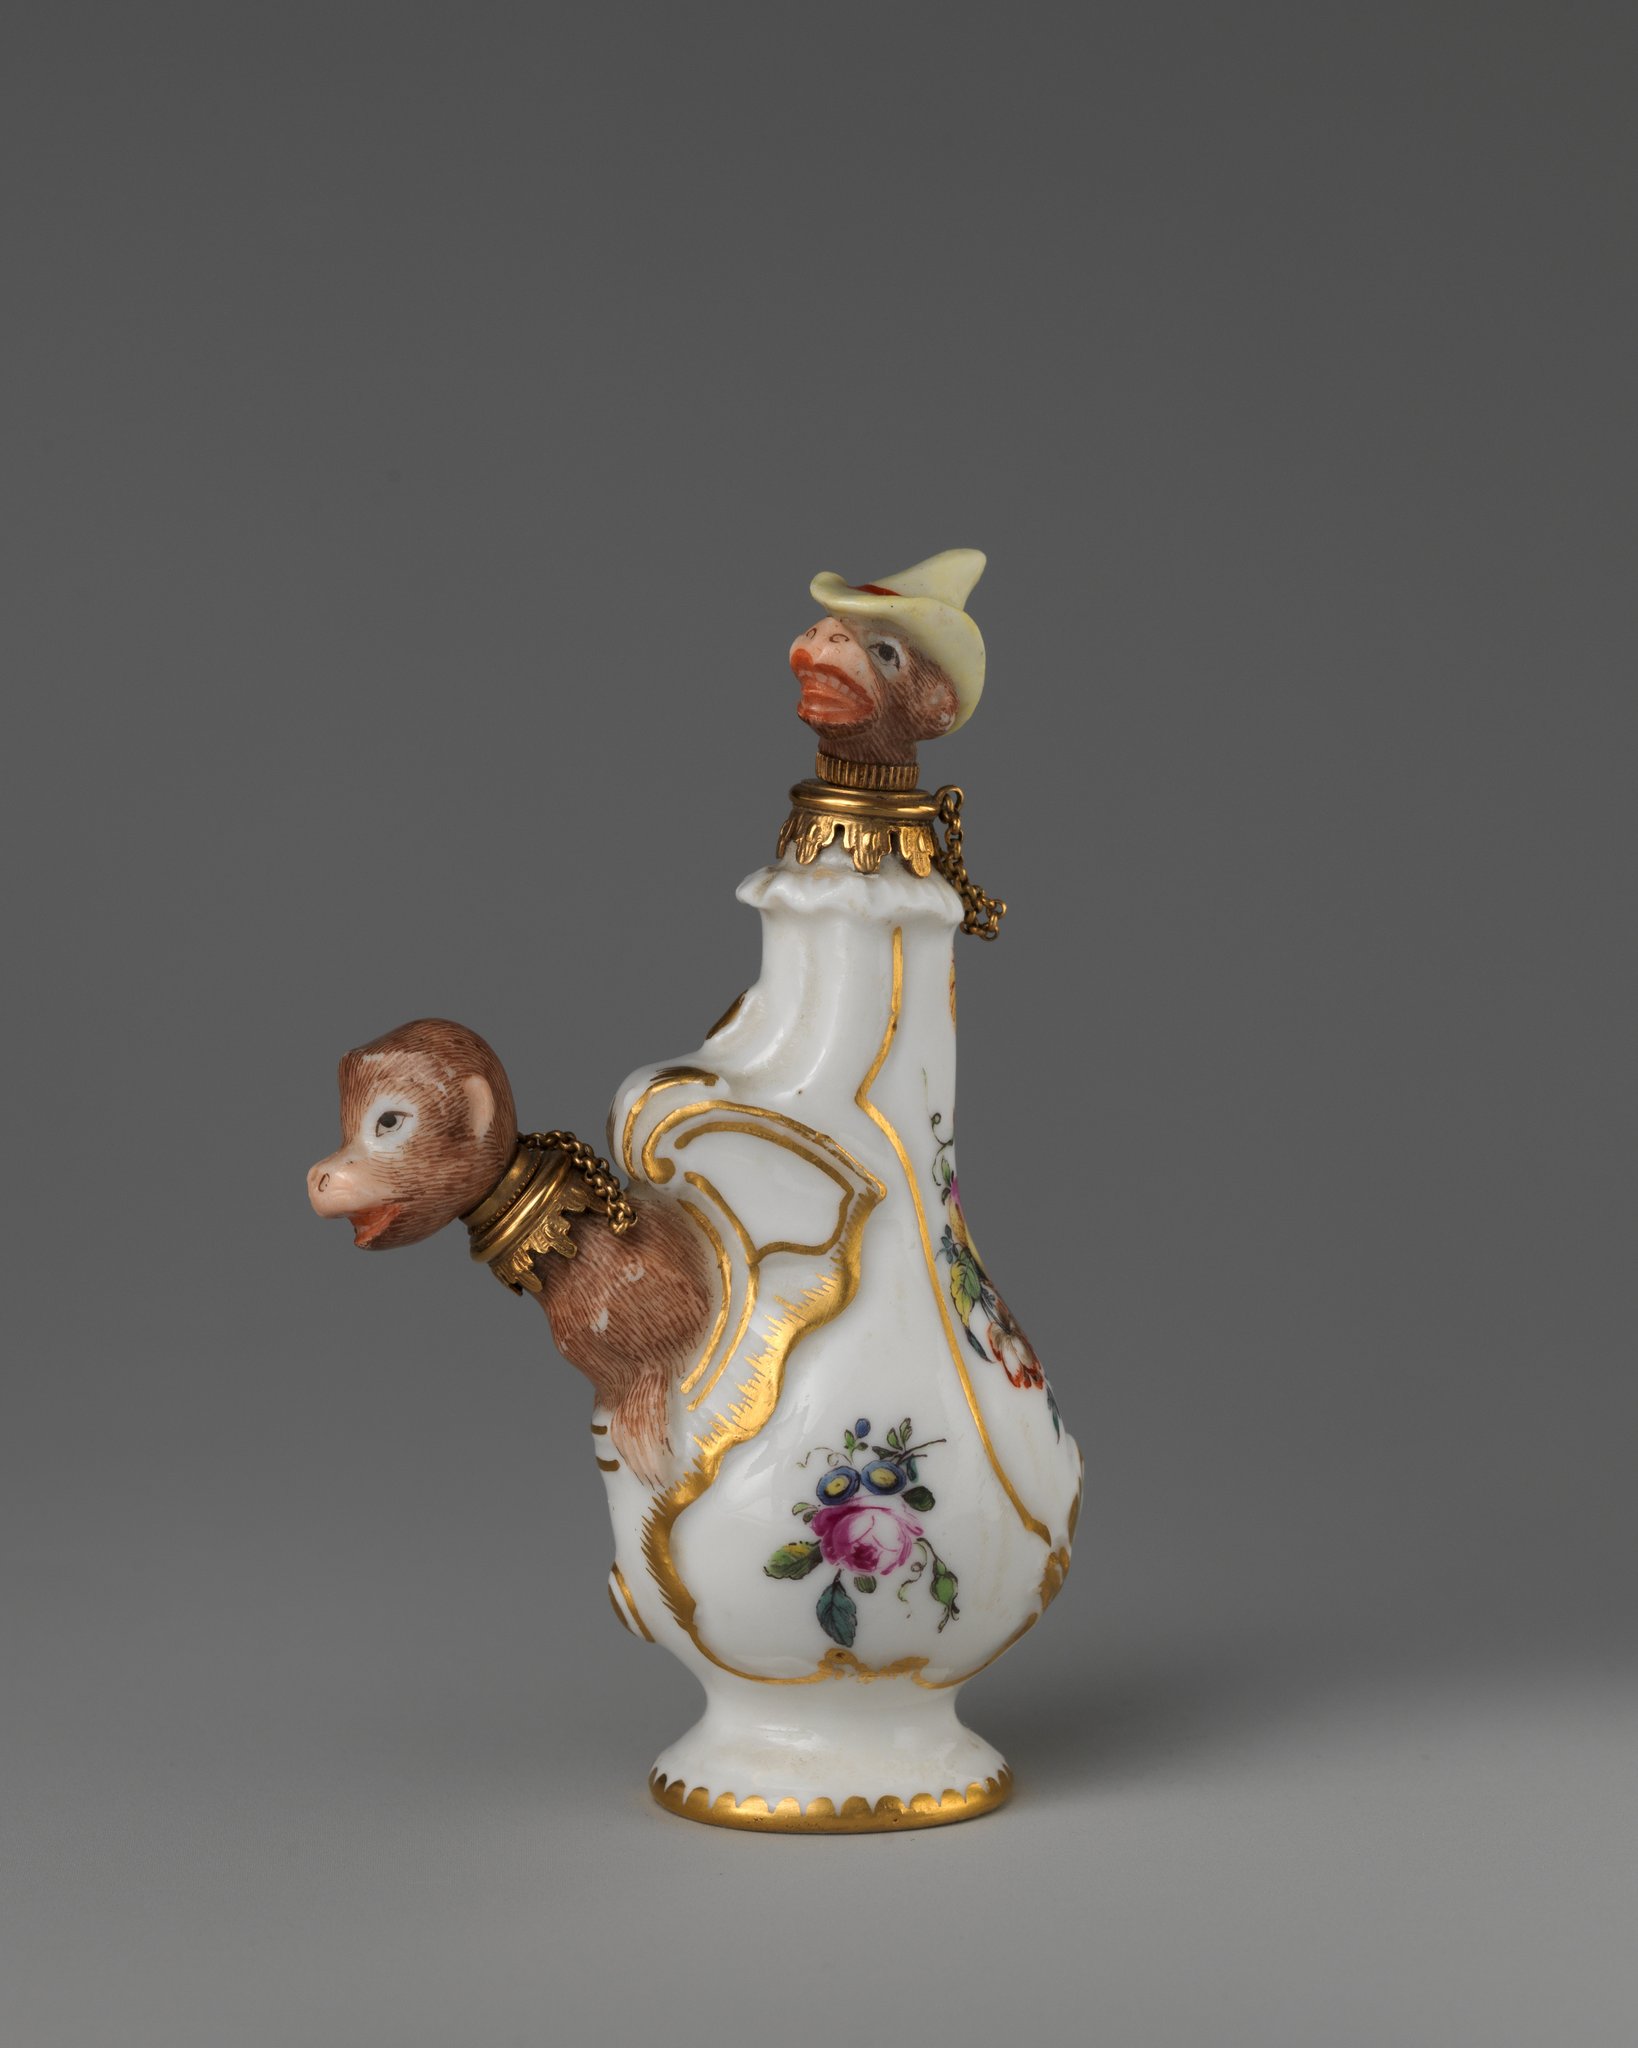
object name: toy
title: Monkeys within vase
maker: chelsea porcelain manufactory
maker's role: factory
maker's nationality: british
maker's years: 1744-1784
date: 1755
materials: soft paste porcelain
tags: monkeys,flowers